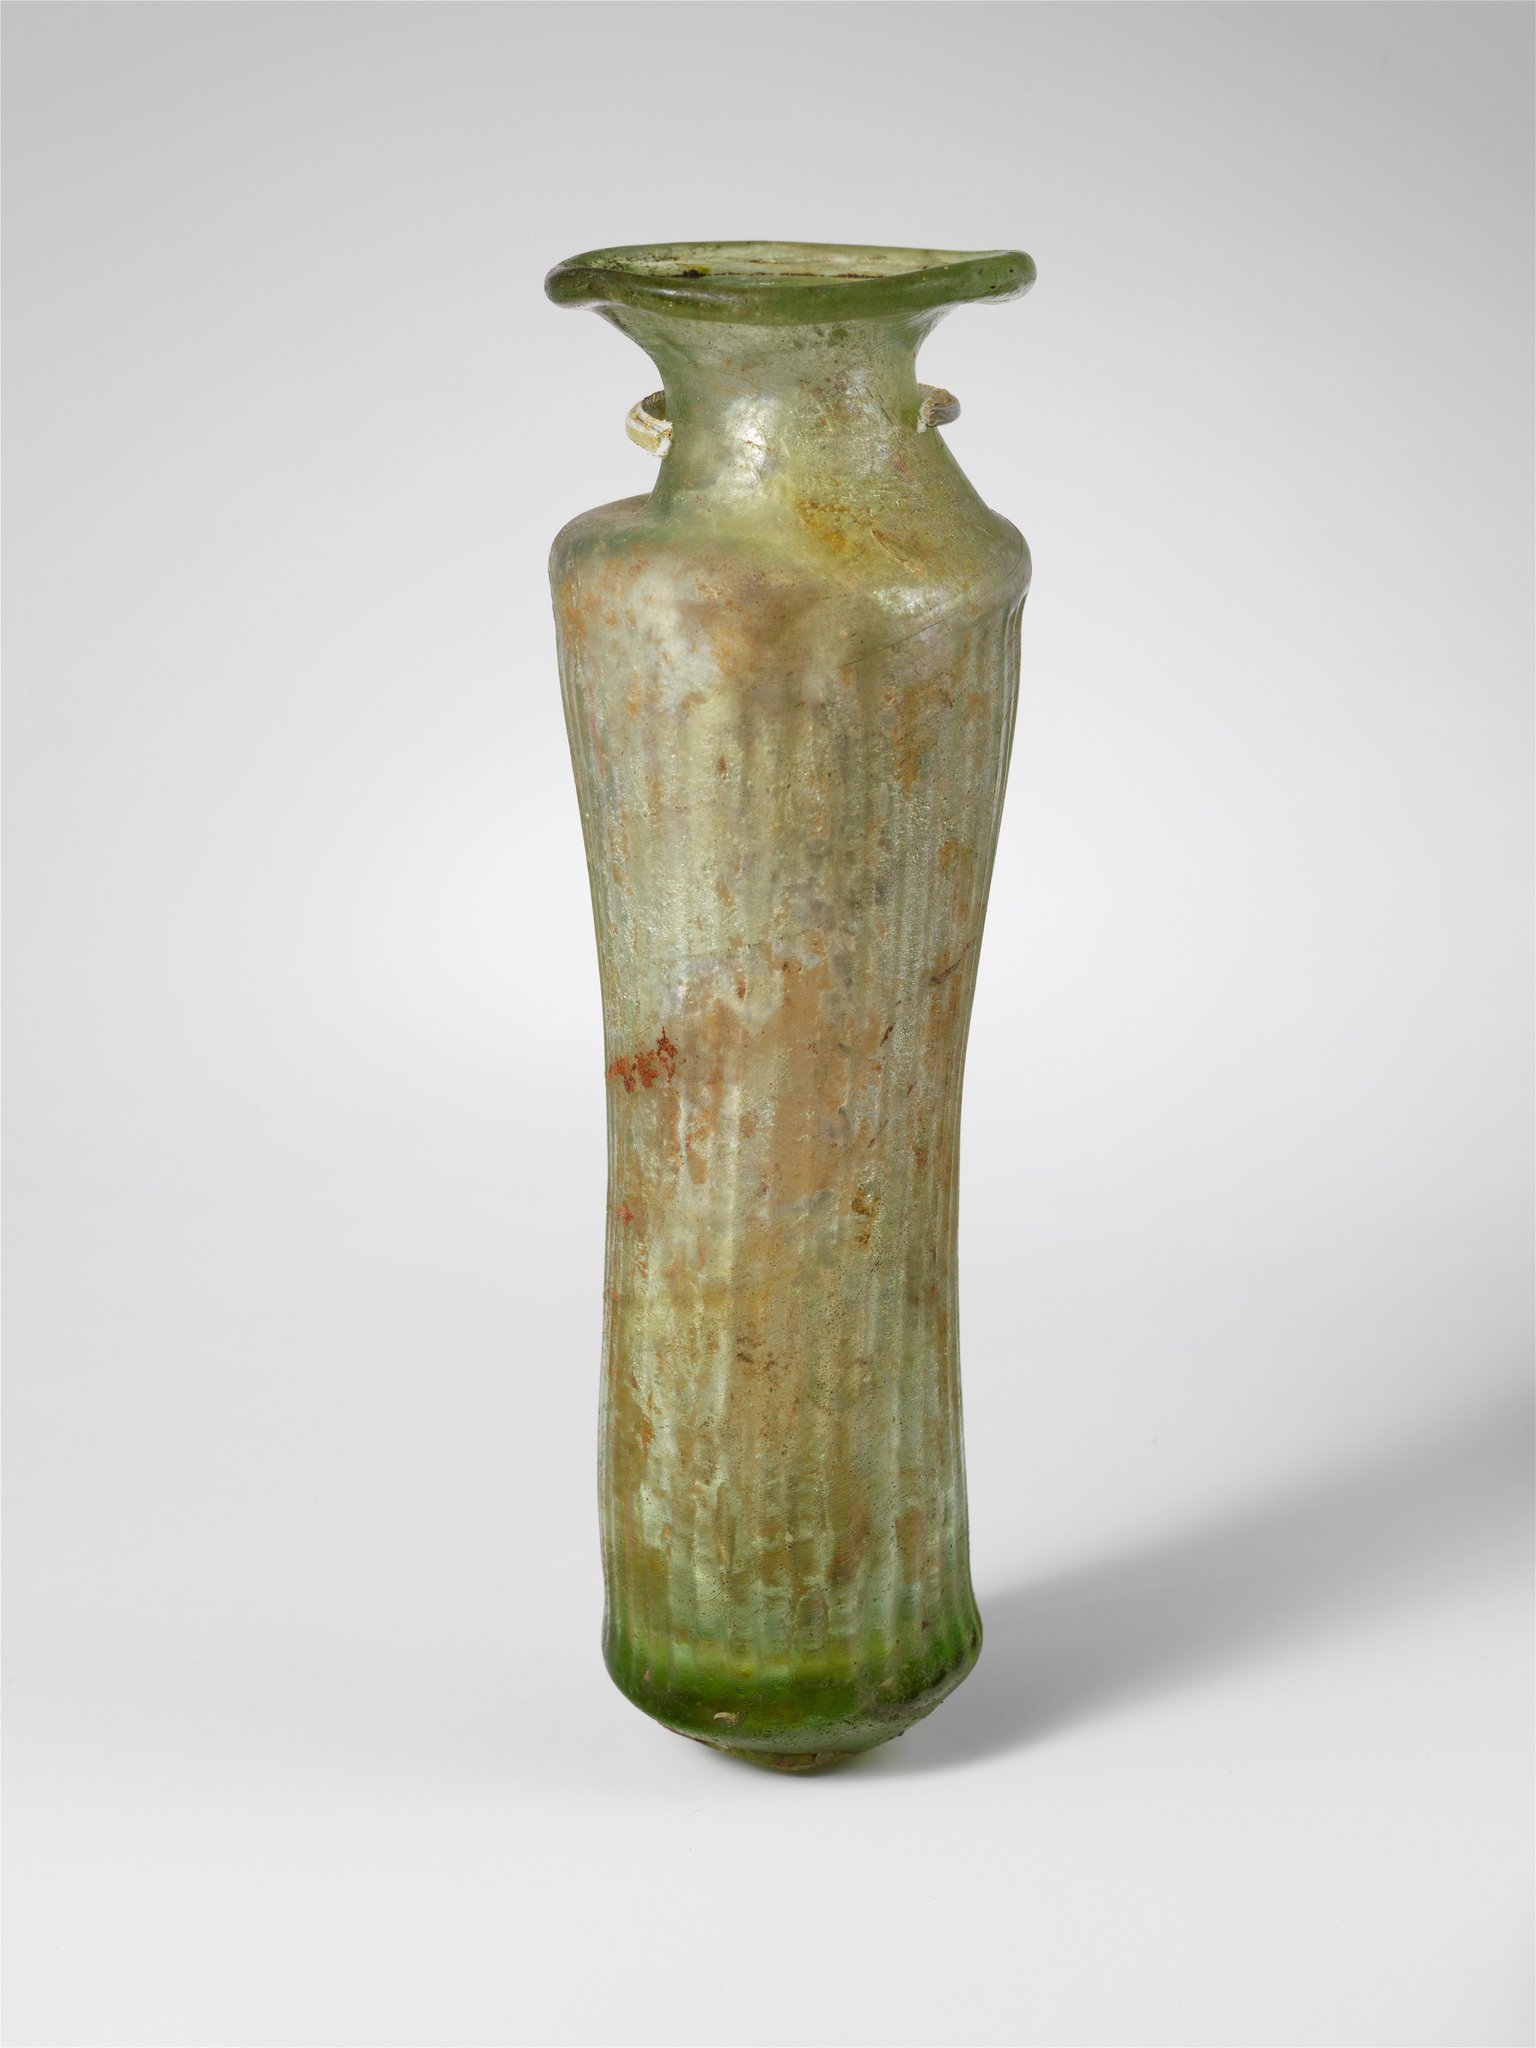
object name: bottle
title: Glass bottle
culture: roman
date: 301-500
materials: glass